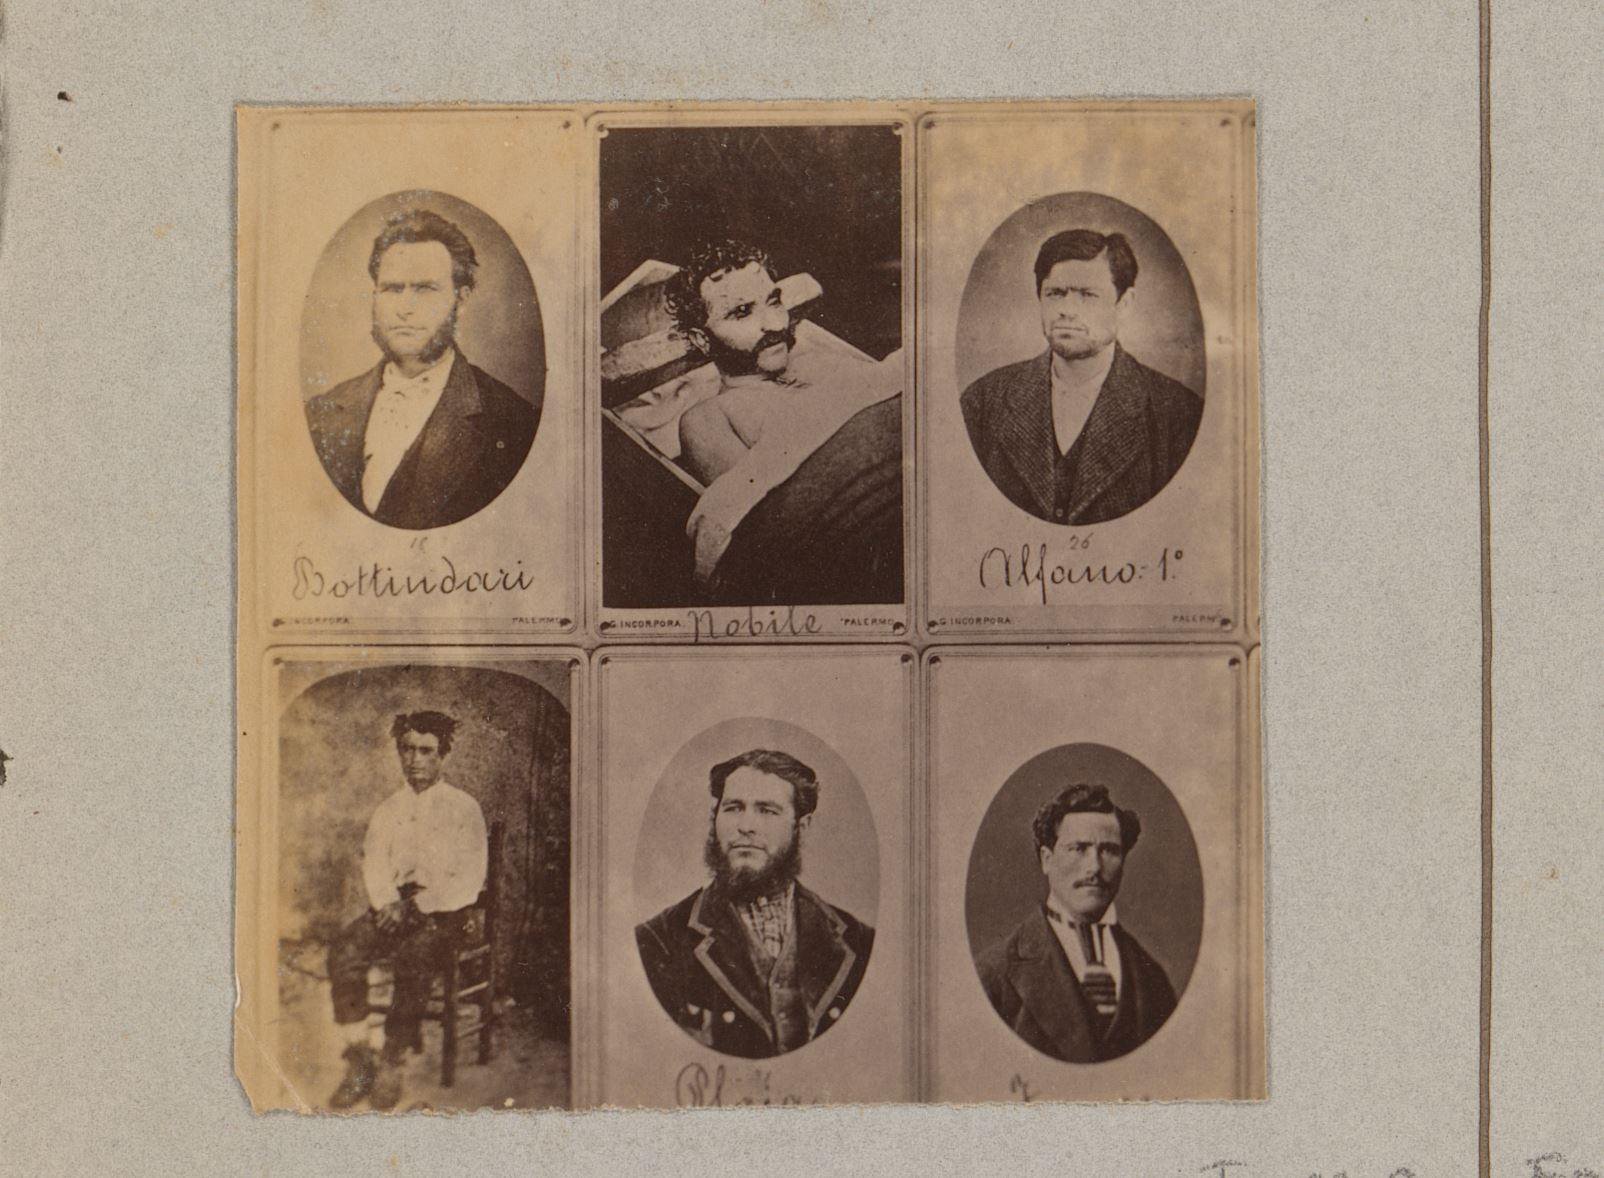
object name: reproduction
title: Fotoreproductie van Siciliaanse brigards door G. Incorpora, volgens methode Monckhoven (8 sec.), verkleind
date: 1887-1888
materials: paper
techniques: albumen print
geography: palermo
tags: adult man, historical persons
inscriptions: inscription: ‘Als voren verkleind, en de reproductie/ verkleind’